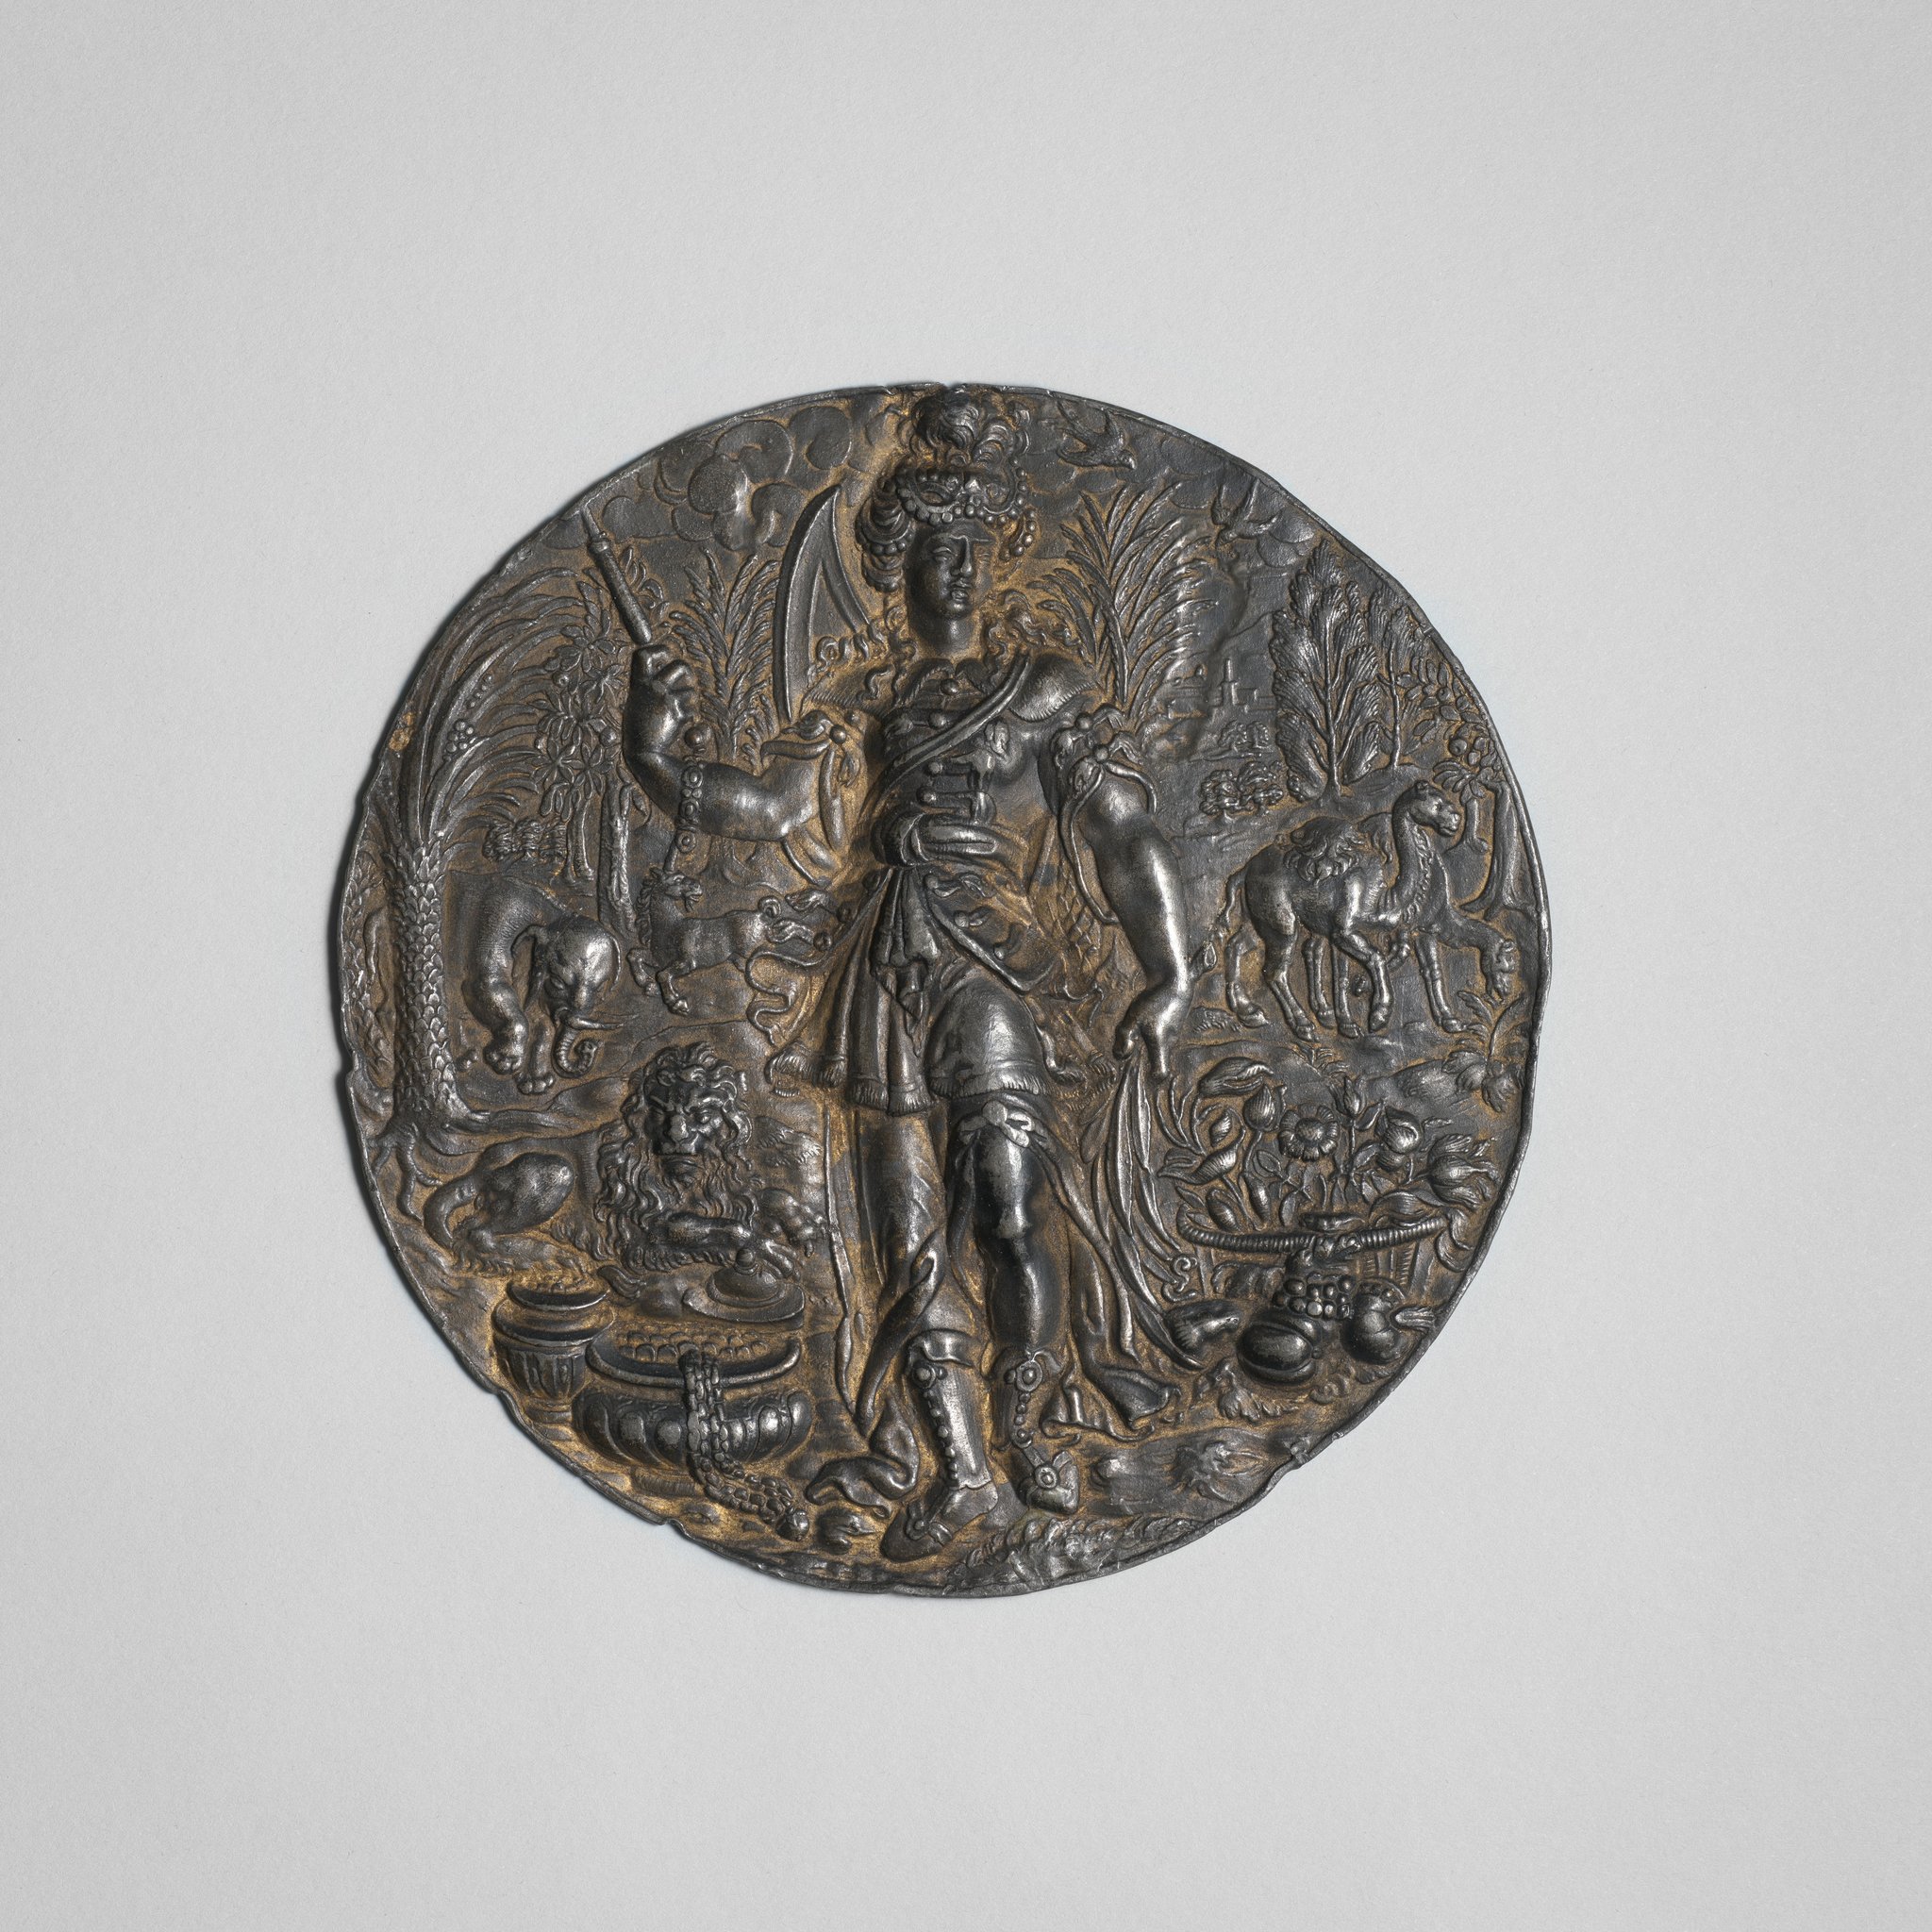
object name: plaquette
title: Personification of Asia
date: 1580-1590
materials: lead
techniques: gilding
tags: animals,men,lions